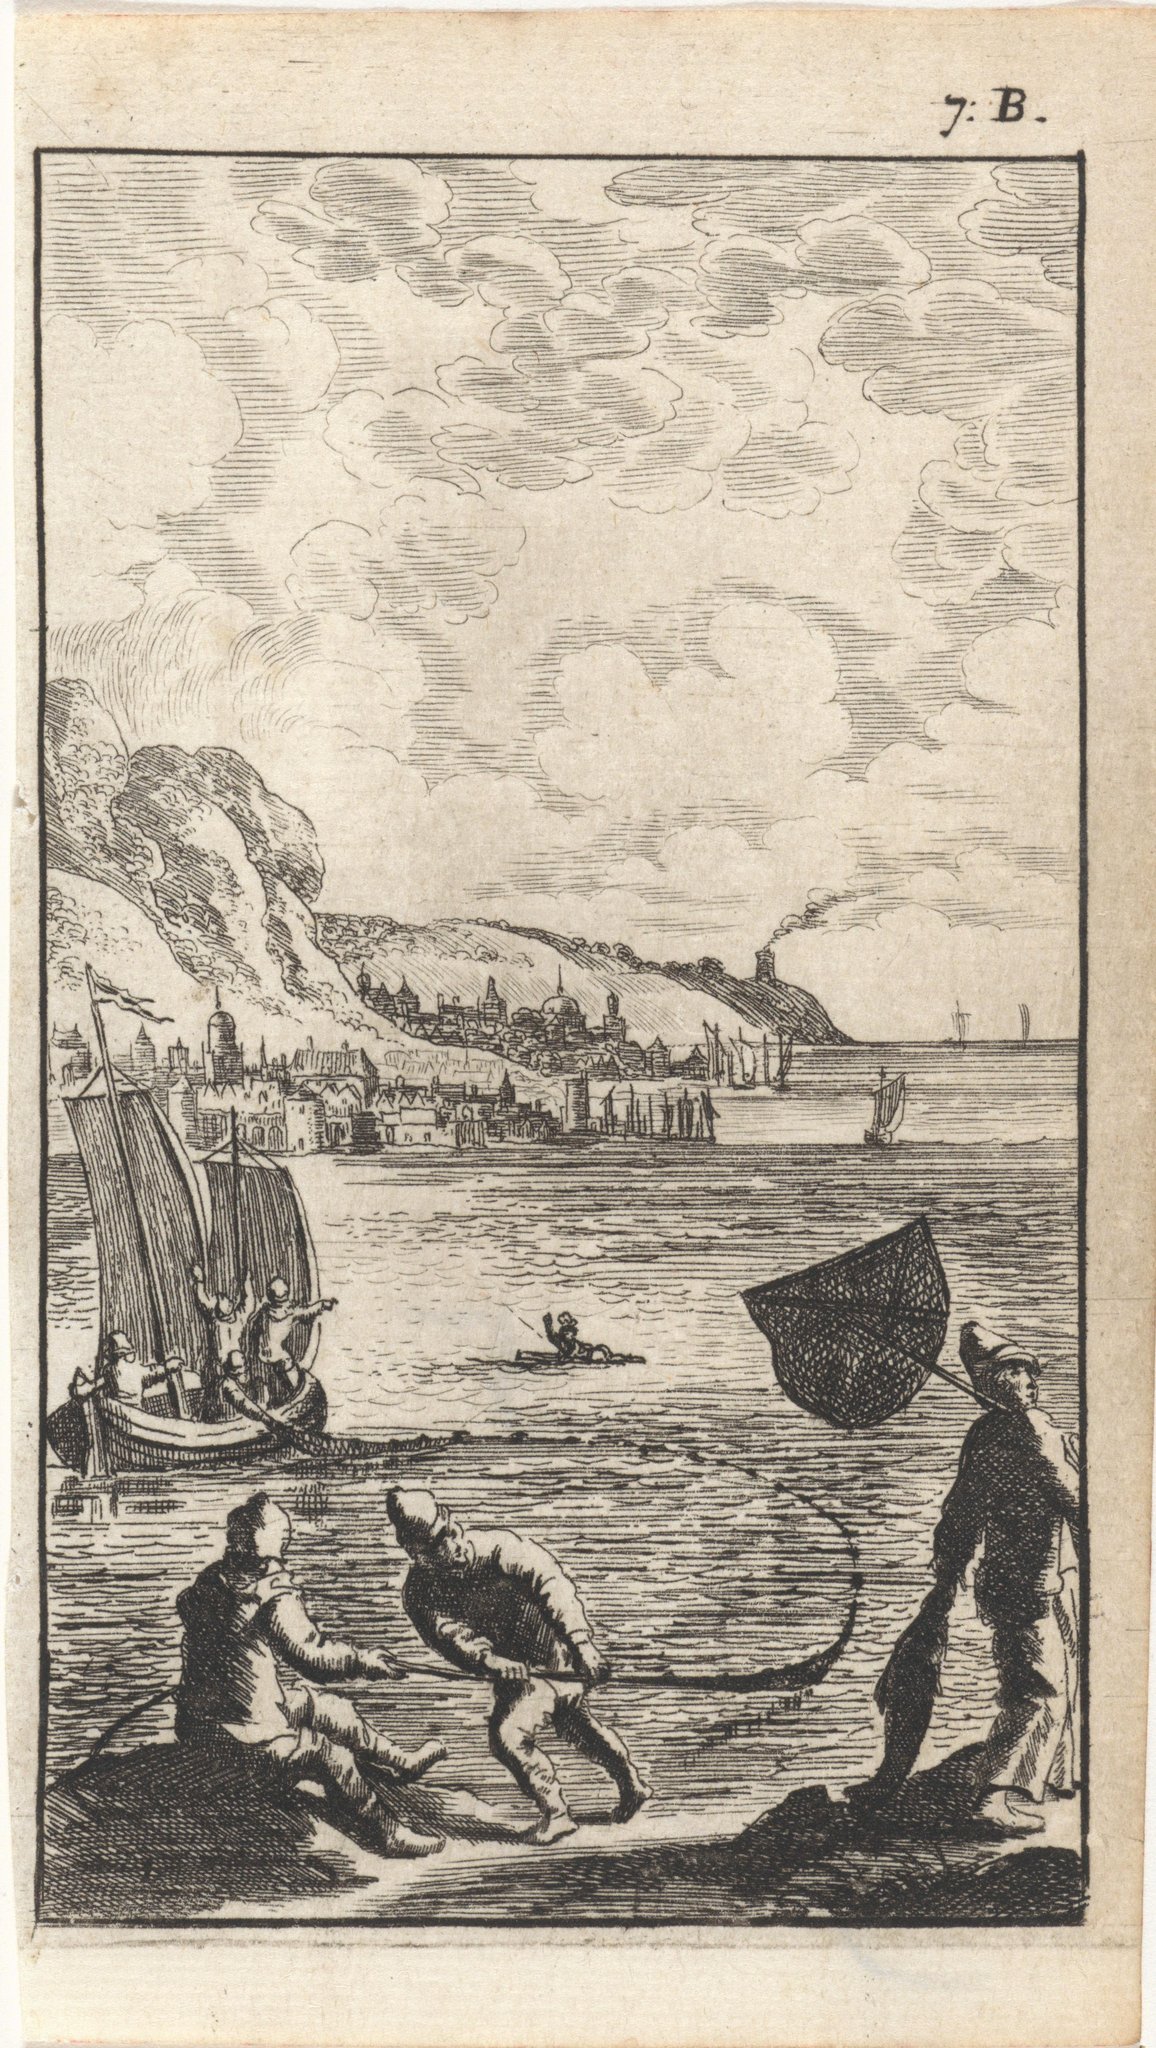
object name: book illustration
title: Kustgezicht met vissers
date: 1666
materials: paper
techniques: etching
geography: netherlands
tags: city-view, and landscape with man-made constructions, fisherman, coast (+ landscape with figures, staffage)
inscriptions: collector's mark: Lugt 2228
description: Langs een bergachtige kustlijn liggen enkele steden. Vooraan zijn vissers met netten in de weer. Ze werken samen met de bemanning van de vissersboot op zee. Achter de boot ligt een drenkeling in het water. Rechtsboven: 7: B.